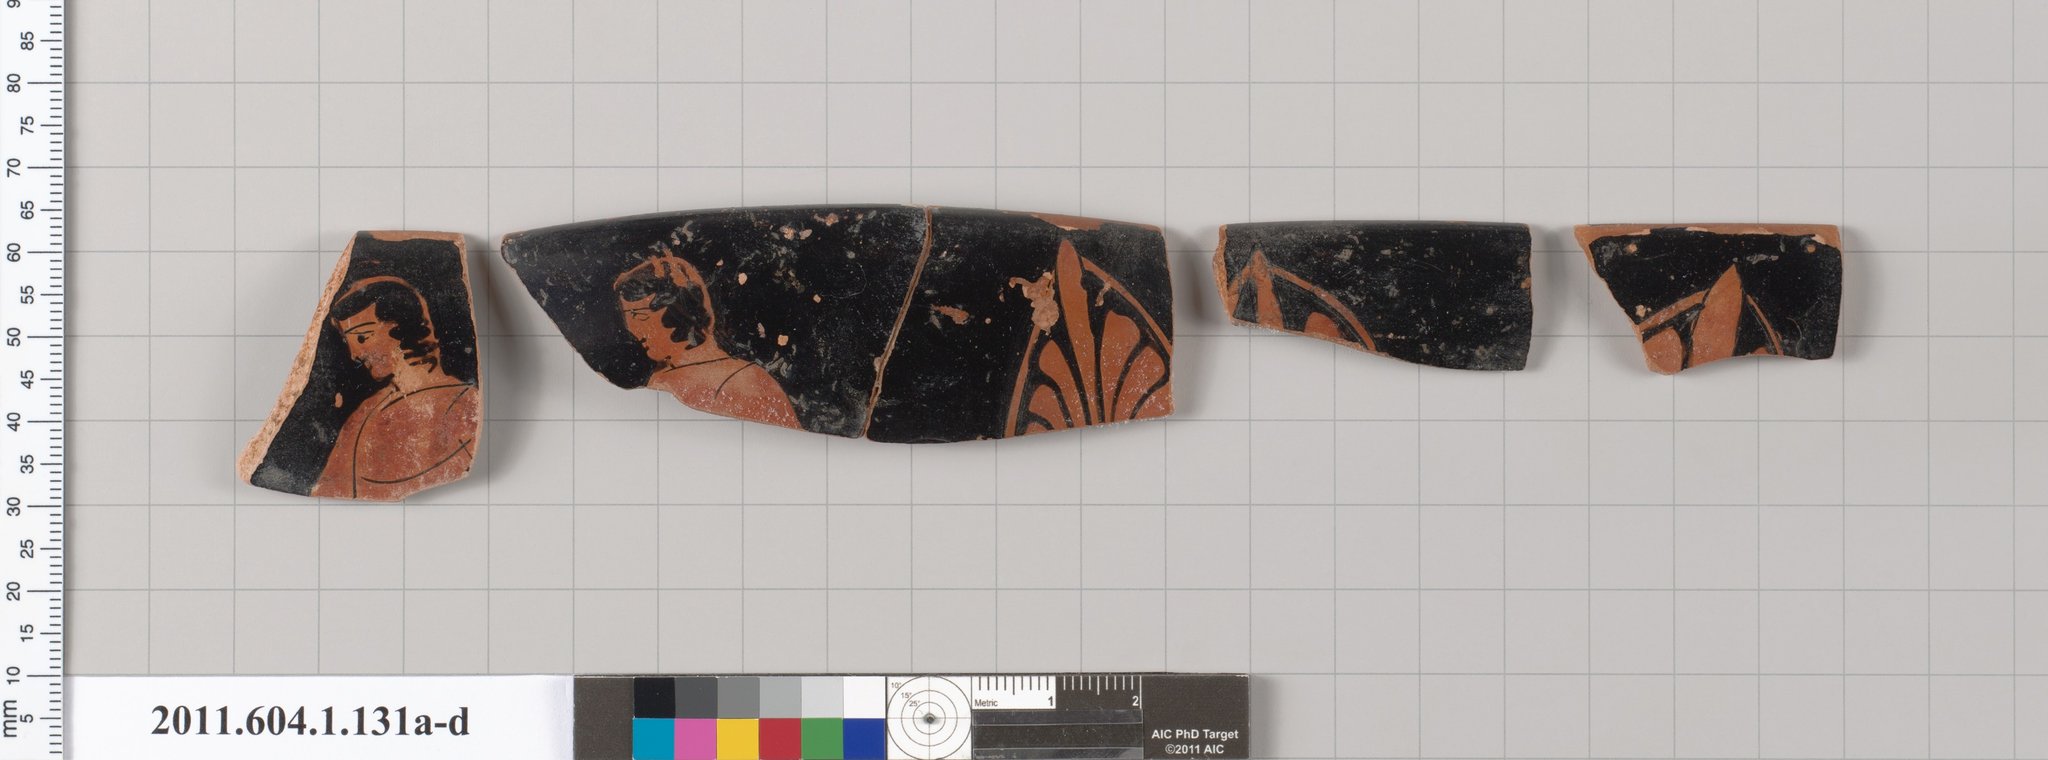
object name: kylix fragment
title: Terracotta rim fragments of a kylix (drinking cup)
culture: greek, attic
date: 475-451 BCE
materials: terracotta